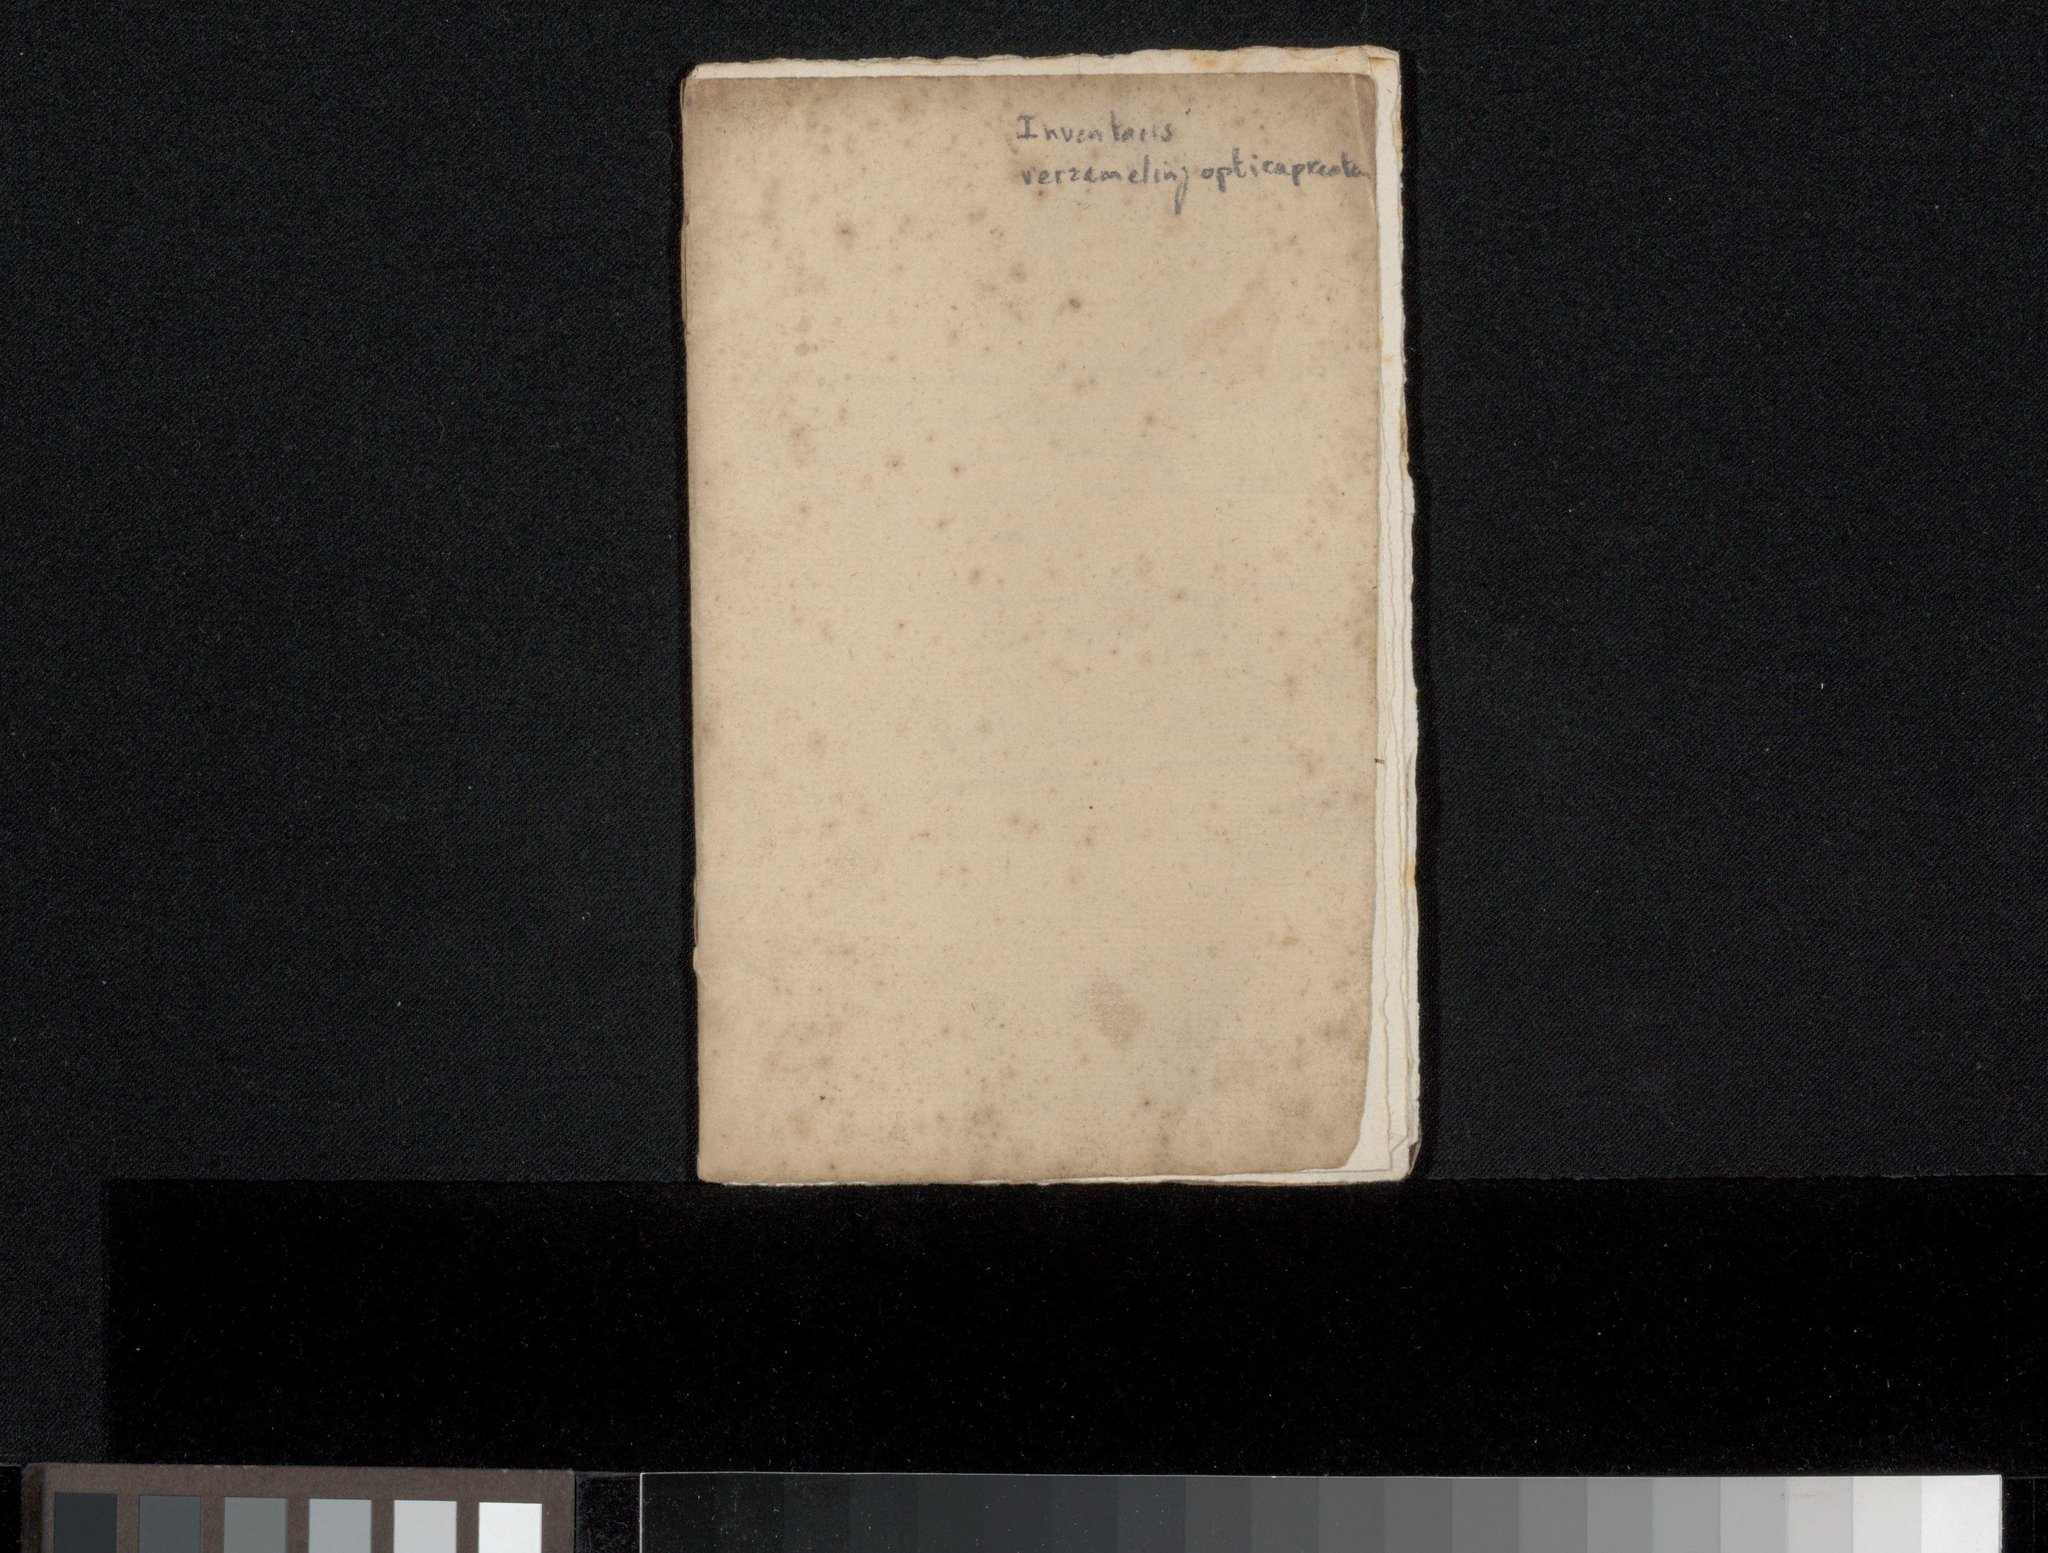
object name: document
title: Inventarislijst van een verzameling opticaprenten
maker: Anonymous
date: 1775-1800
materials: ink, paper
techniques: writing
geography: netherlands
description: Inventarislijst van een verzameling opticaprenten van een onbekende verzamelaar.